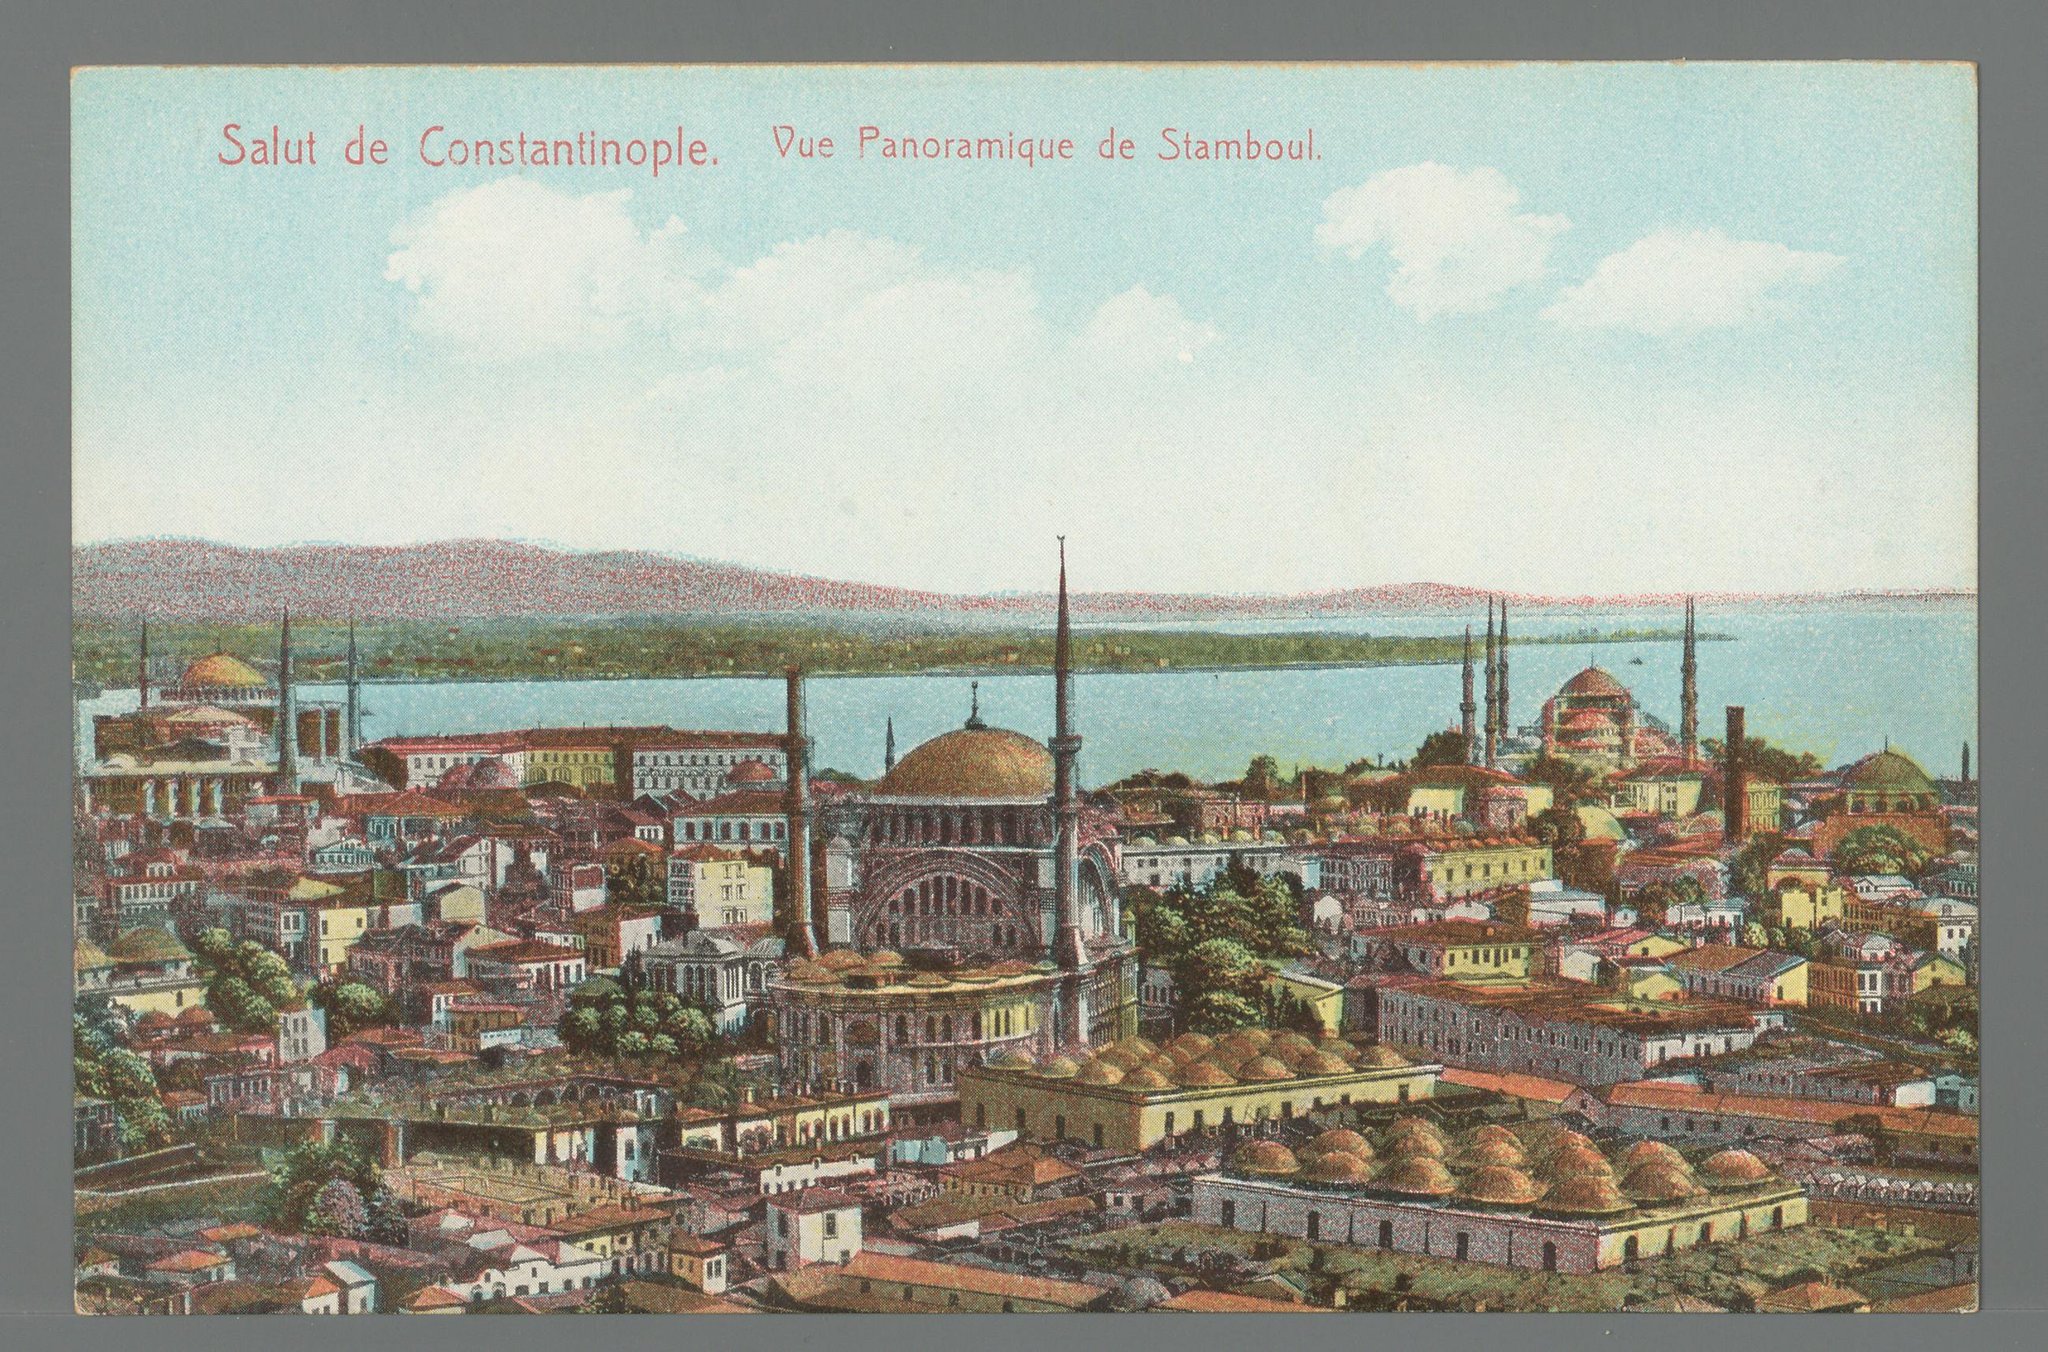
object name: ansichtkaart, prentbriefkaart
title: Vue Panoramique de Stamboul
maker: Anonymous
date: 1906-1920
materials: cardboard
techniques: lithograph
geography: constantinople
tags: temple, shrine ~ islam, mohammedanism, prospect of city, town panorama, silhouette of city